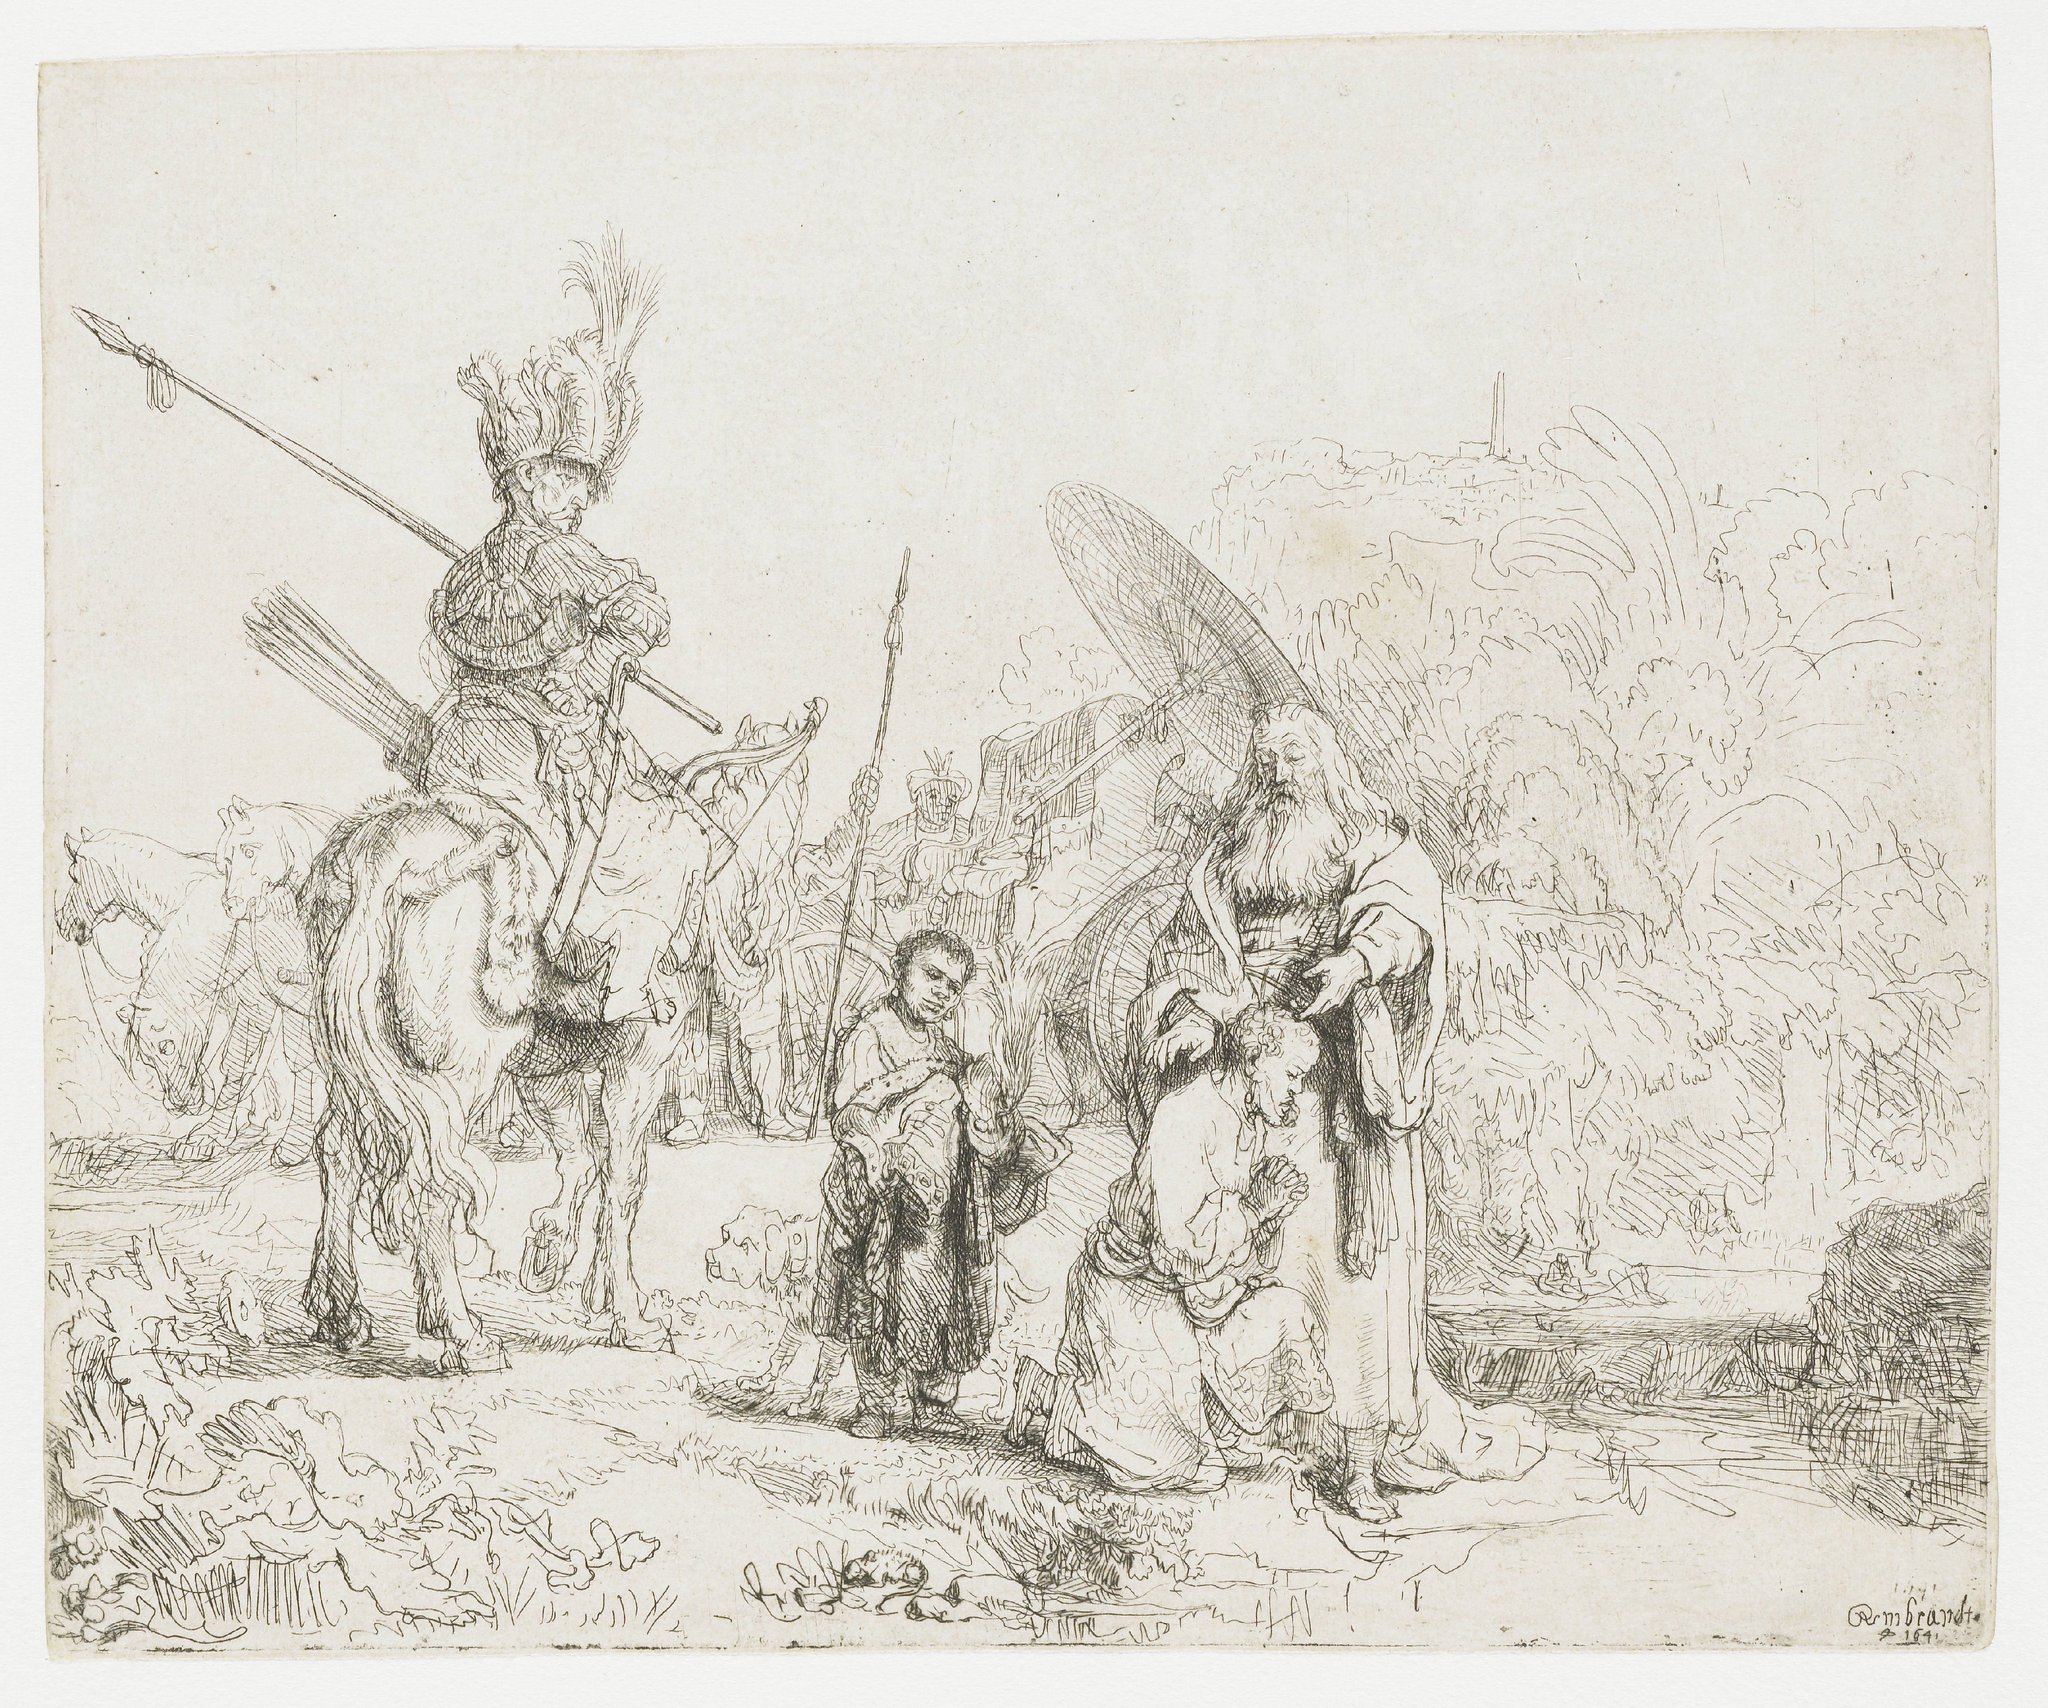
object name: print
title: The Baptism of the Eunuch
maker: rembrandt van rijn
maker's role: draughtsman, painter, print maker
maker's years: 1606-1669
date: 1641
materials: paper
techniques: etching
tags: philip baptizes the eunuch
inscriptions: mark: Lugt 533 b, signature and date: ‘Rembrandt f. 1641’, mark: Lugt 2000, mark: Lugt 312 b, mark: Lugt 2228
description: During a journey, the apostle Philip met a court official of the Ethiopian queen Candace, who was reading the Book of Isaiah. He asked Philip to explain a certain passage and the apostle told him about Christ. The man then asked Philip to baptize him. Rembrandt included all sorts of attributes, from a parasol to an extravagant feathered headdress, to emphasize the caravan’s African origin.